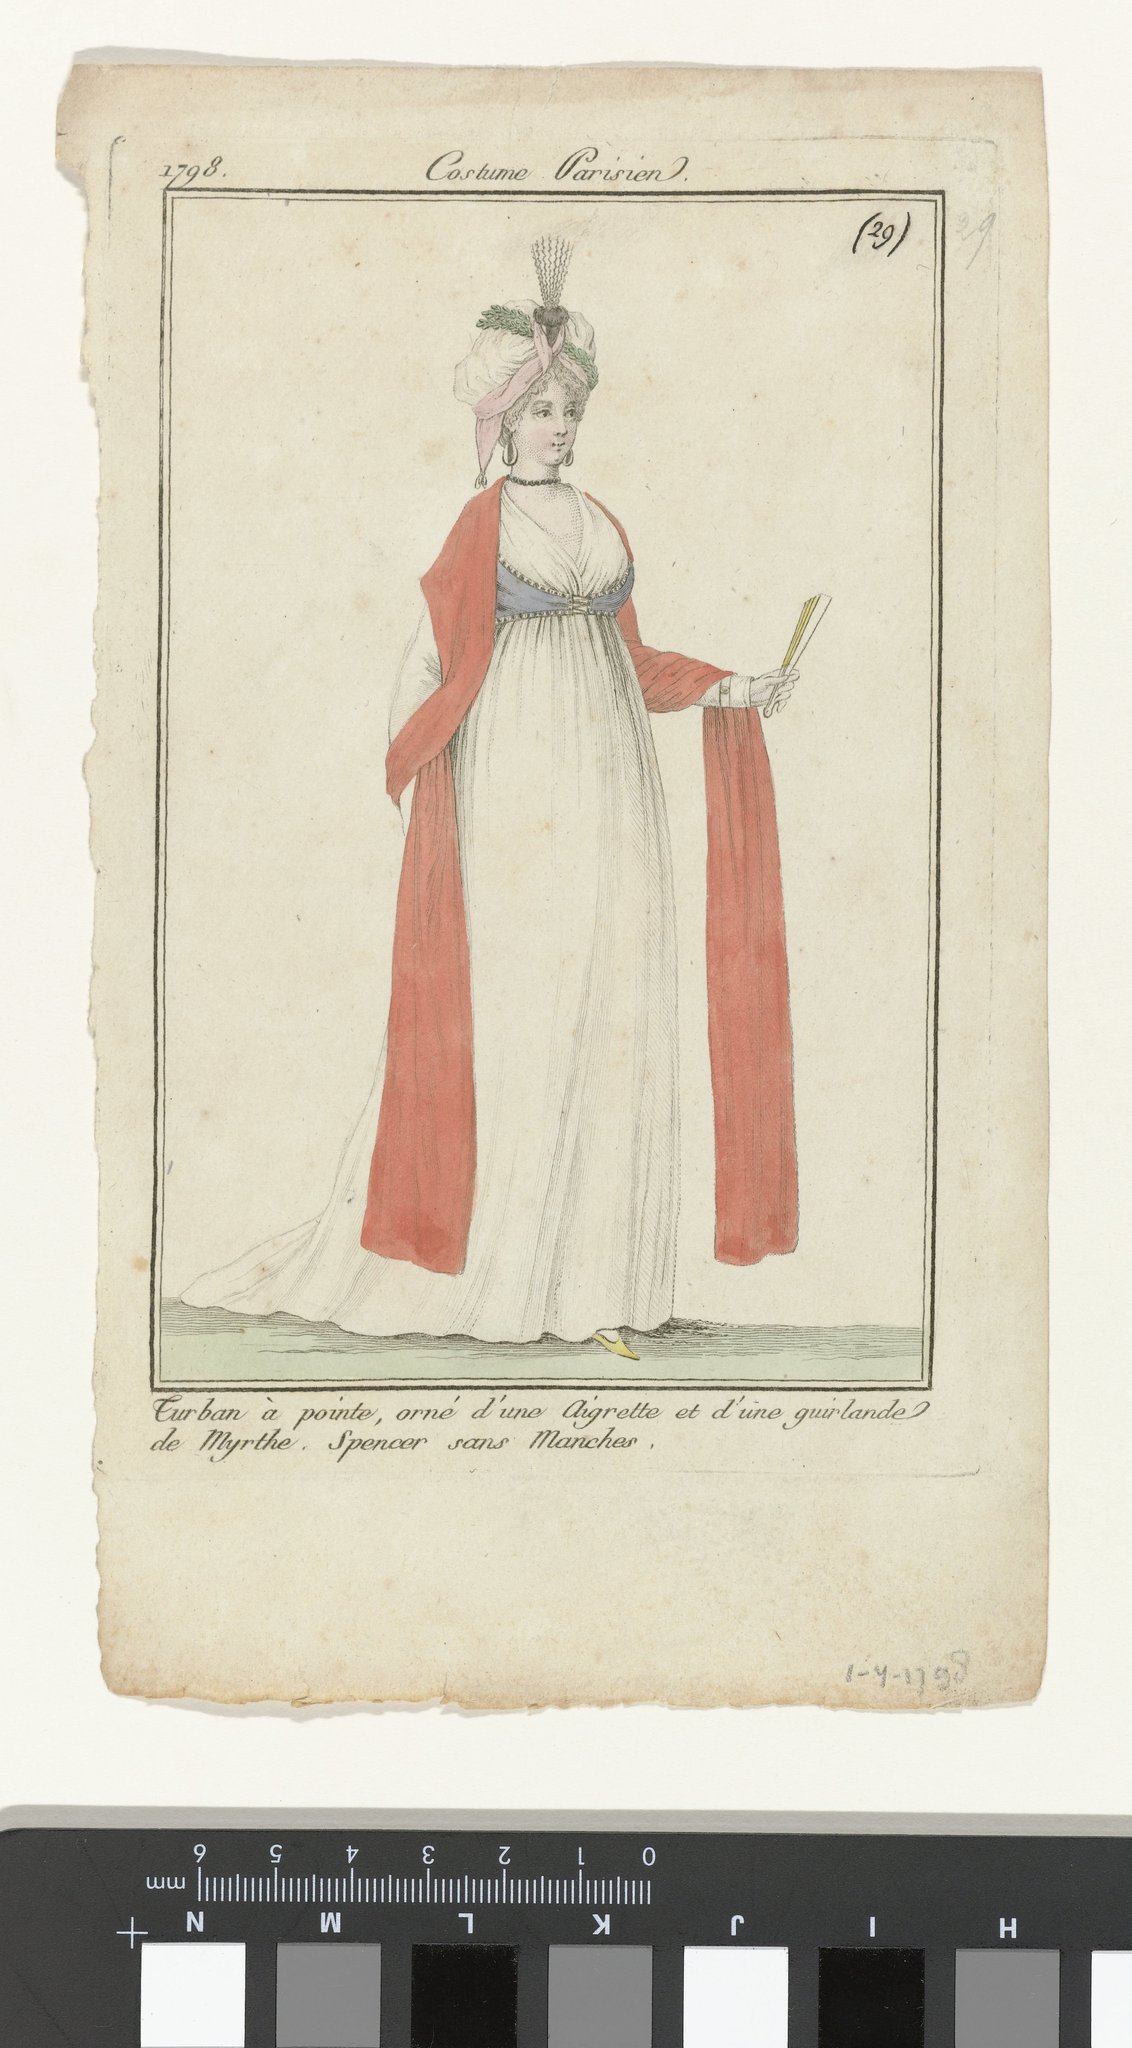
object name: fashion print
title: Journal des Dames et des Modes, Costume Parisien, 1 avril 1798, (29): Turban à point (...)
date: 1798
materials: paper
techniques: engraving, hand coloring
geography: paris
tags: ear-rings (+ women's clothes), head-gear: turban (+ women's clothes), clothing for the upper part of the body (shawl) (+ women's clothes), clothing for the upper part of the body (spencer) (+ women's clothes), fashion plates, shoes, sandals (+ women's clothes), dress, gown (+ women's clothes), fan (+ women's clothes), necklace (+ women's clothes)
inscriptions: caption: ‘Turban à pointe, orné d'une aigrette et d'une guirlande de myrthe. Spencer sans manches.’, title: ‘Costume Parisien.’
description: Staande vrouw met op het hoofd een tulband met slip, versierd met een aigrette en een guirlande van mirte. Zij draagt een spencer zonder mouwen op een japon met lange mouwen en sleep. Accessoires: oorbellen, collier, lange sjaal om de schouders, armband(?), waaier, schoen met puntige neus. De prent maakt deel uit van het modetijdschrift Journal des Dames et des Modes, uitgegeven door Sellèque, Parijs, 1797-1839.